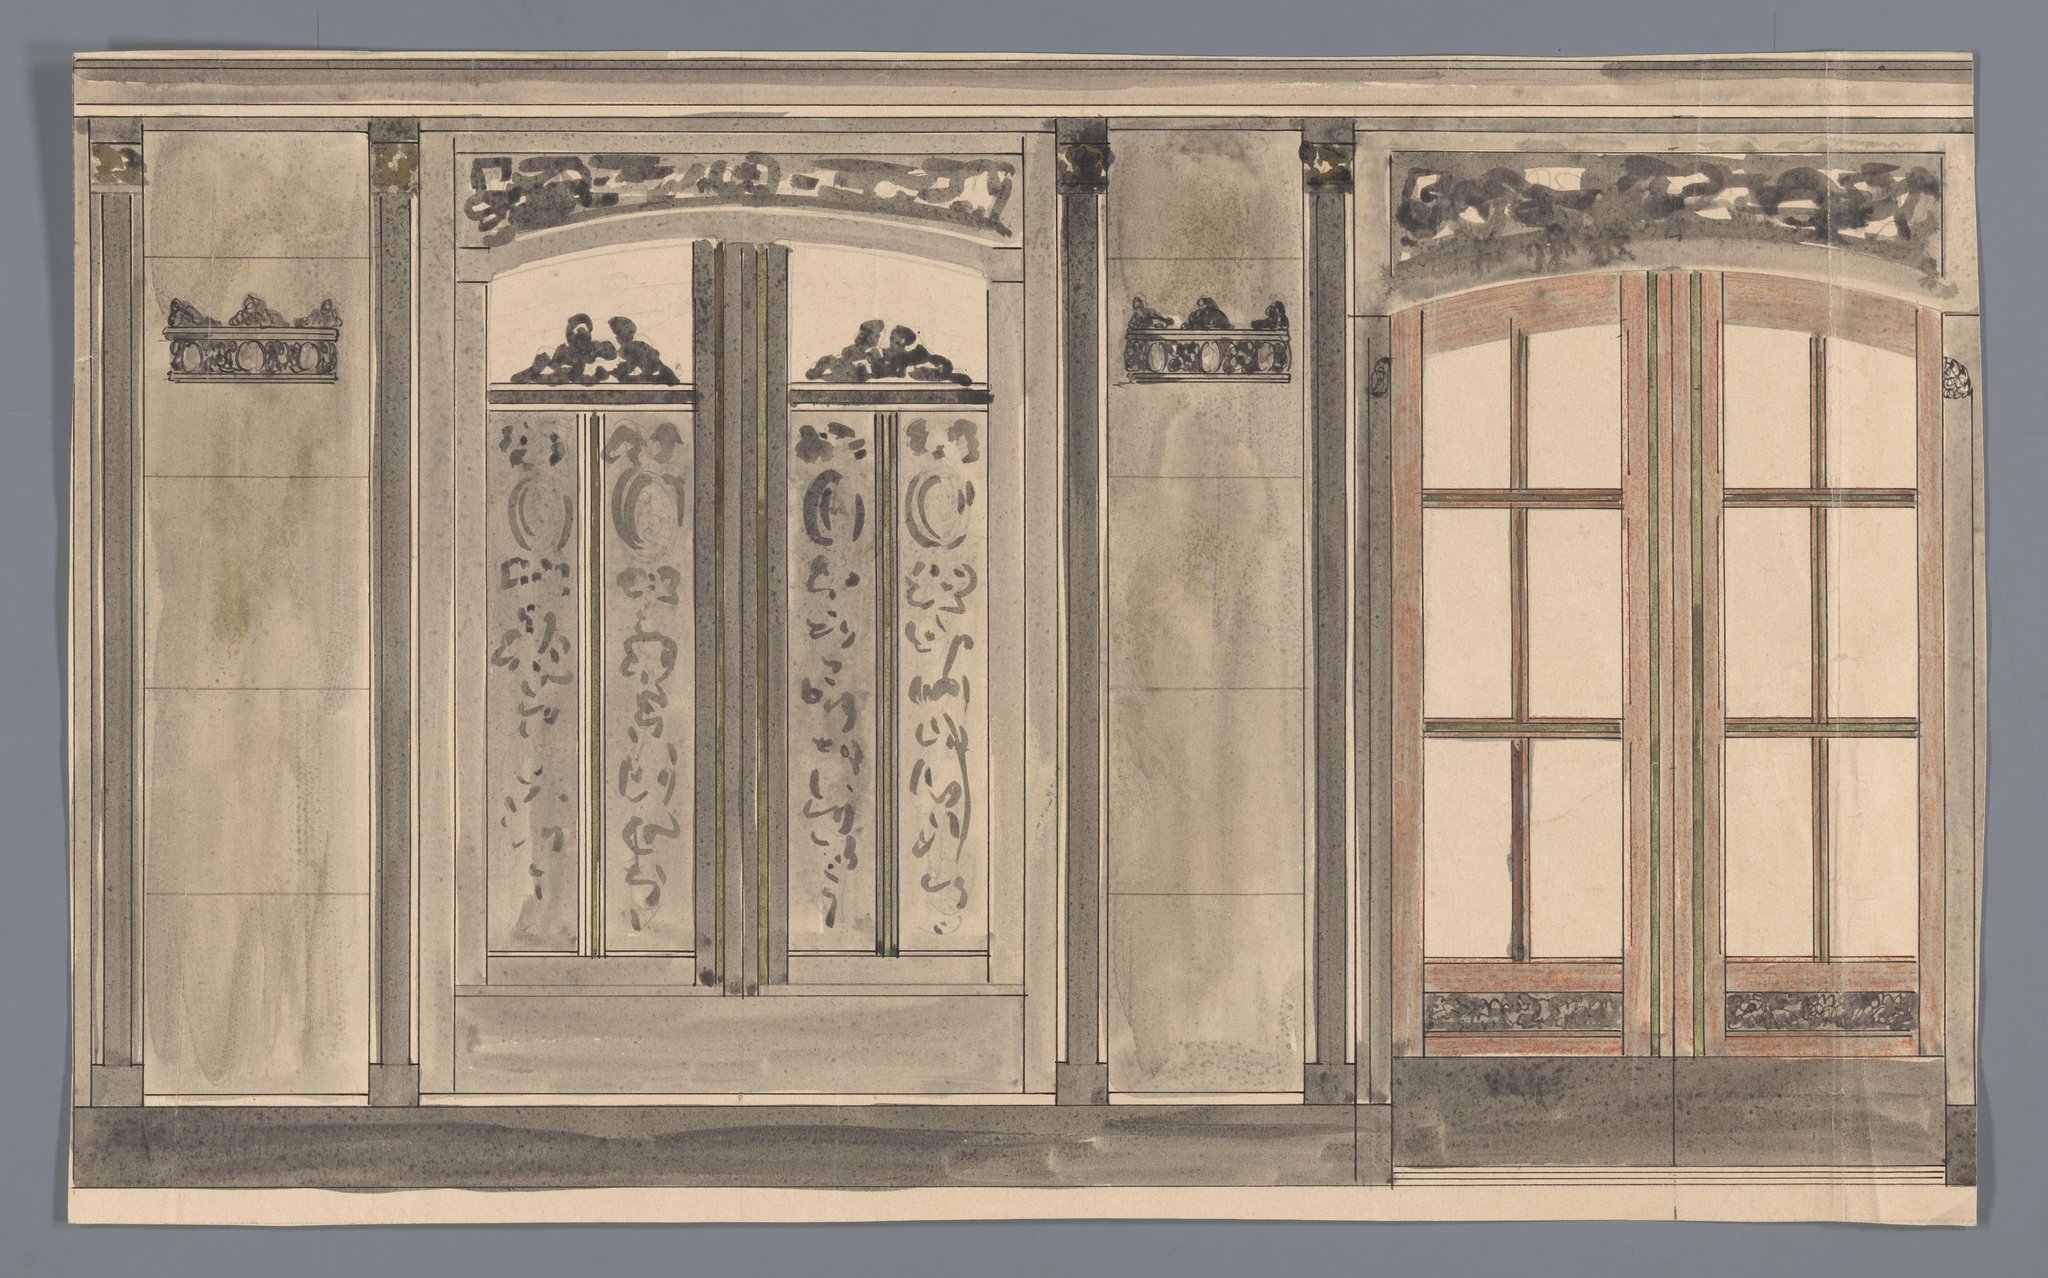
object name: design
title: Ontwerp voor wand met dubbele deuren van een mailboot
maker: carel adolph lion cachet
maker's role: draughtsman, print maker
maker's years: 1864-1945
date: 1874-1945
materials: chalk, ink, paper, pencil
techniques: brush, pen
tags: names of artefacts and man-made objects (buildings excluded), door, interior of the house, parts of ship's interior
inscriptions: inscription: ‘Mailboot’